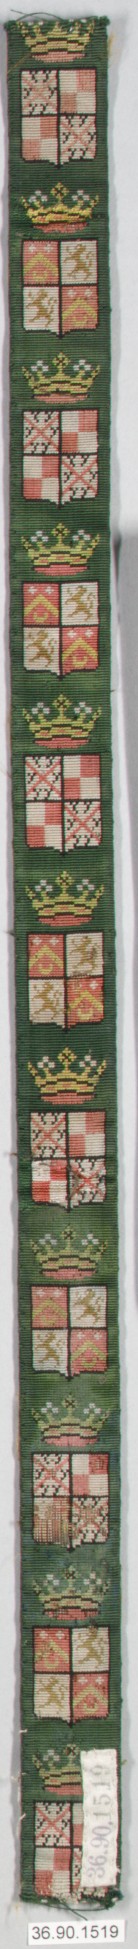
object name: galloon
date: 1701-1900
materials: silk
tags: coat of arms